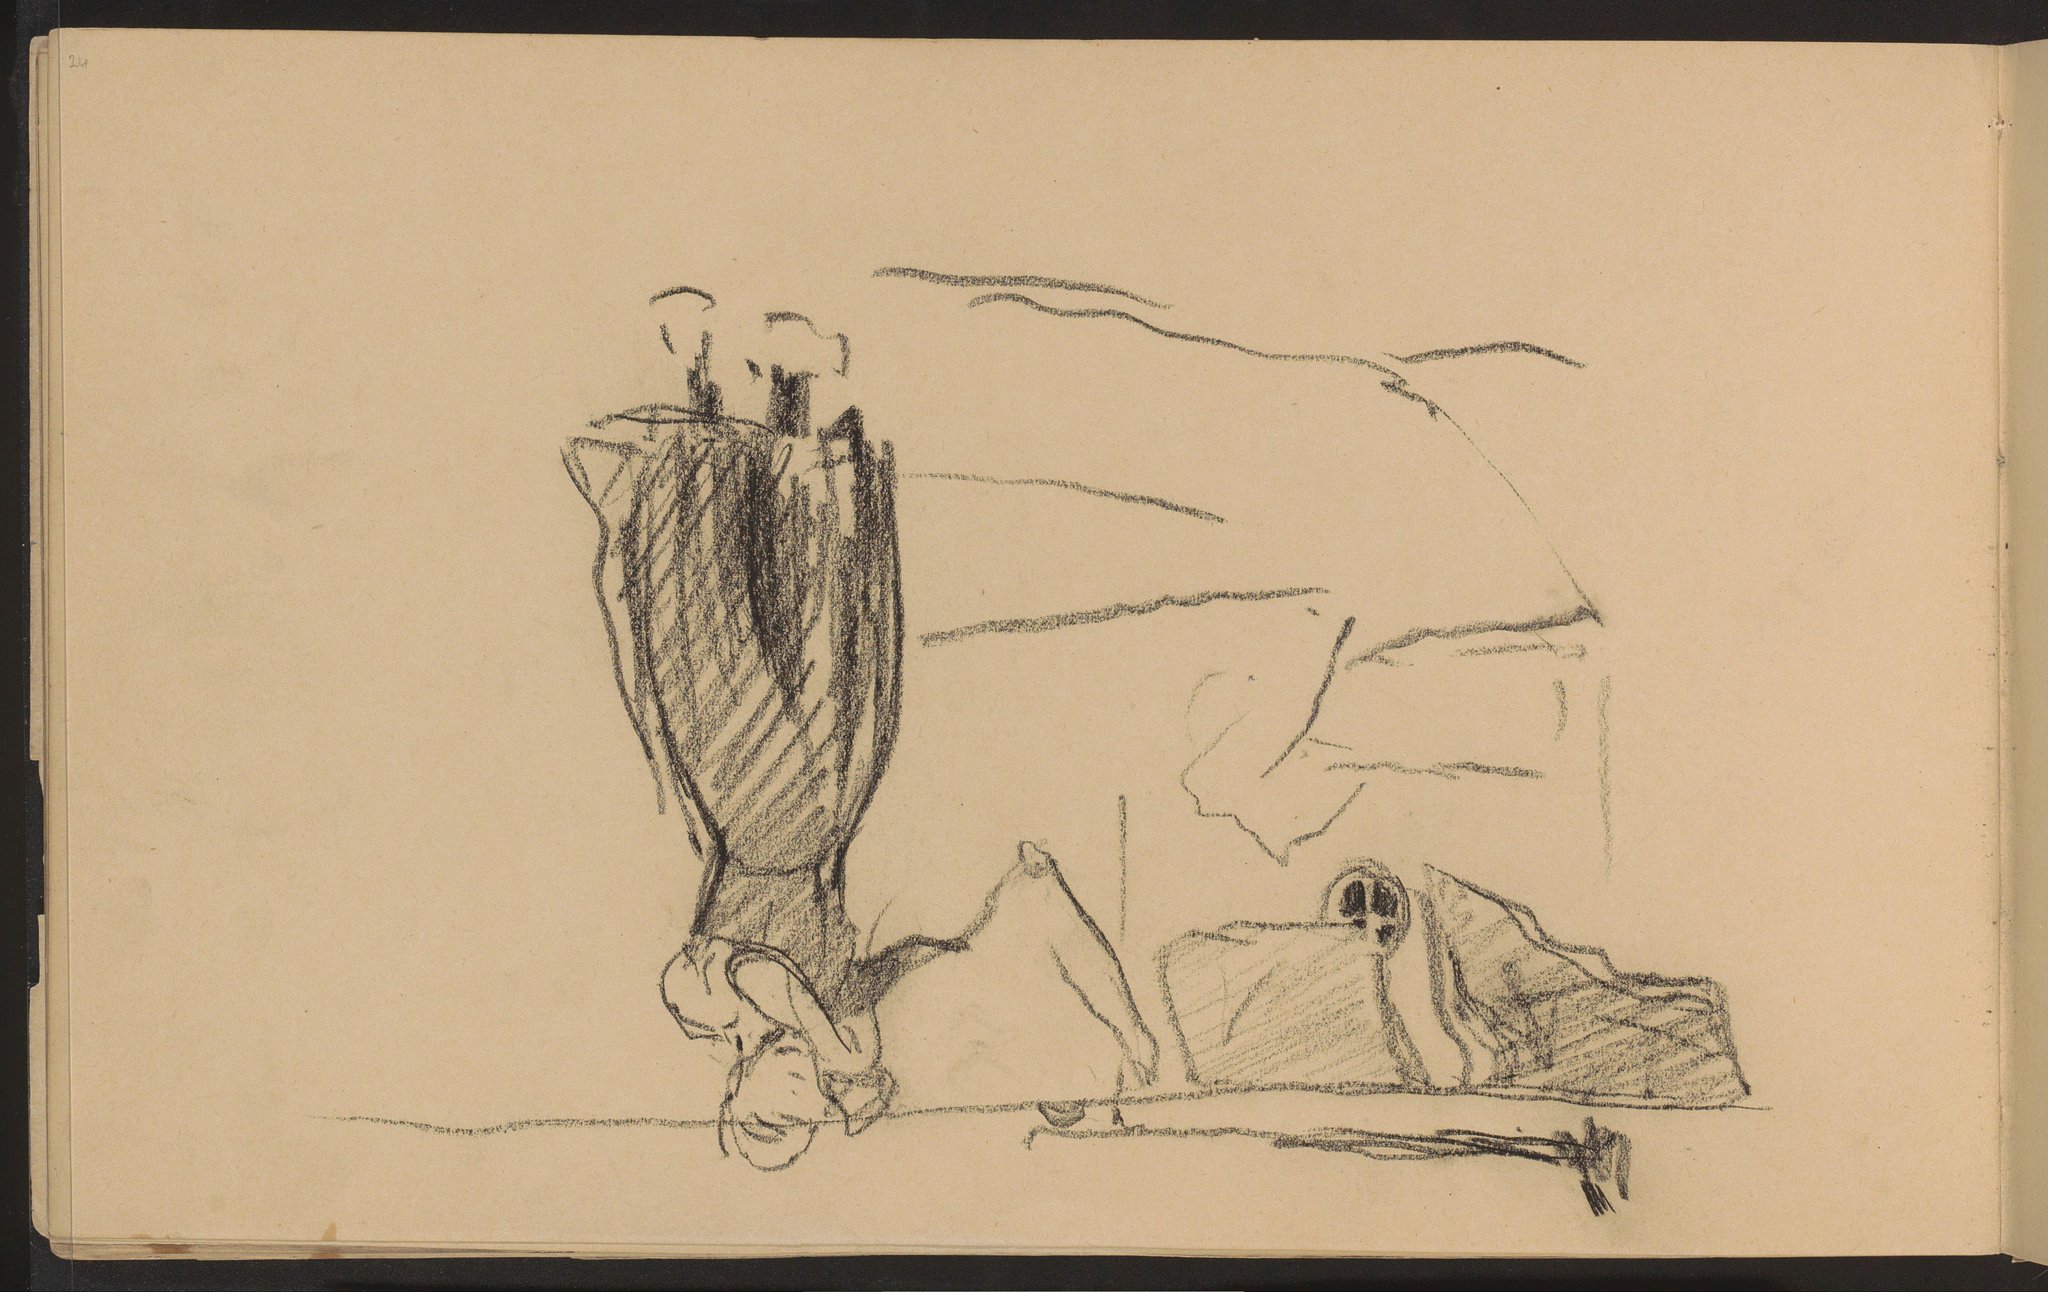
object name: sketchbook leaf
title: Vrouw bij een waslijn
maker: willem witsen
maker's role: draughtsman, painter, print maker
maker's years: 1860-1923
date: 1897-1910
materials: chalk, paper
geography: amsterdam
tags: adult woman, civic architecture; edifices; dwellings, accessories and implements ~ laundering, e.g. clothes-peg, drying frame, (empty) washing line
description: Op de achtergrond een gebouw. Pagina 24 uit een schetsboek met 19 bladen.